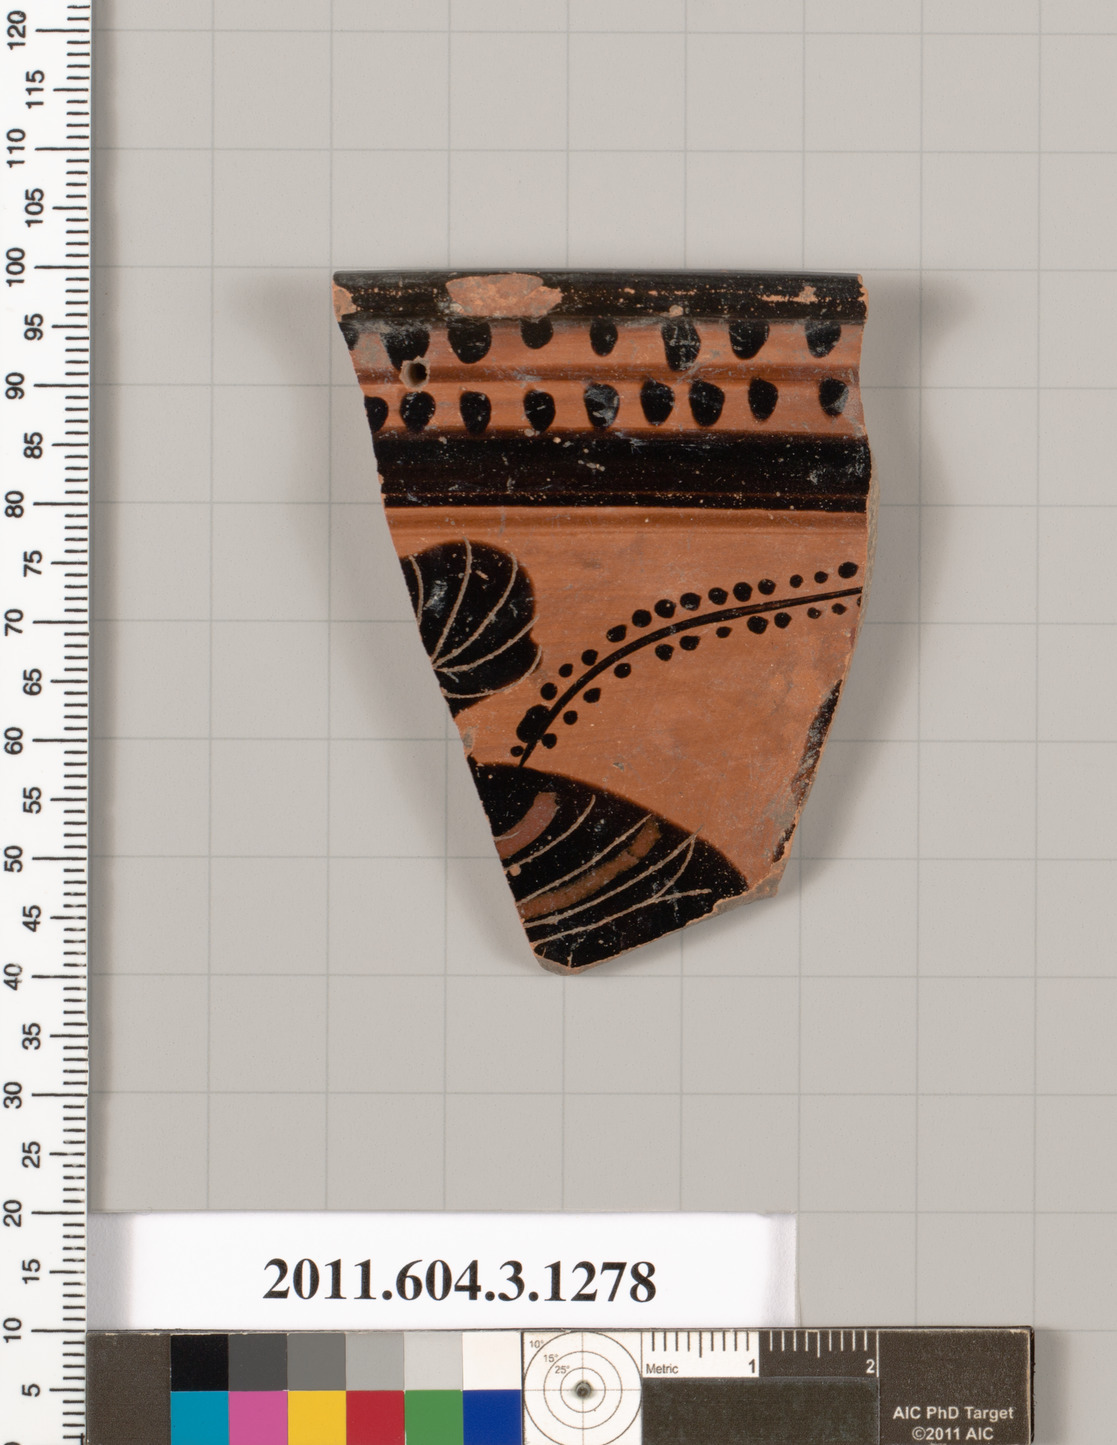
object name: skyphos fragment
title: Terracotta rim fragment of a skyphos (deep drinking cup)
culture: greek, attic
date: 500 BCE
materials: terracotta